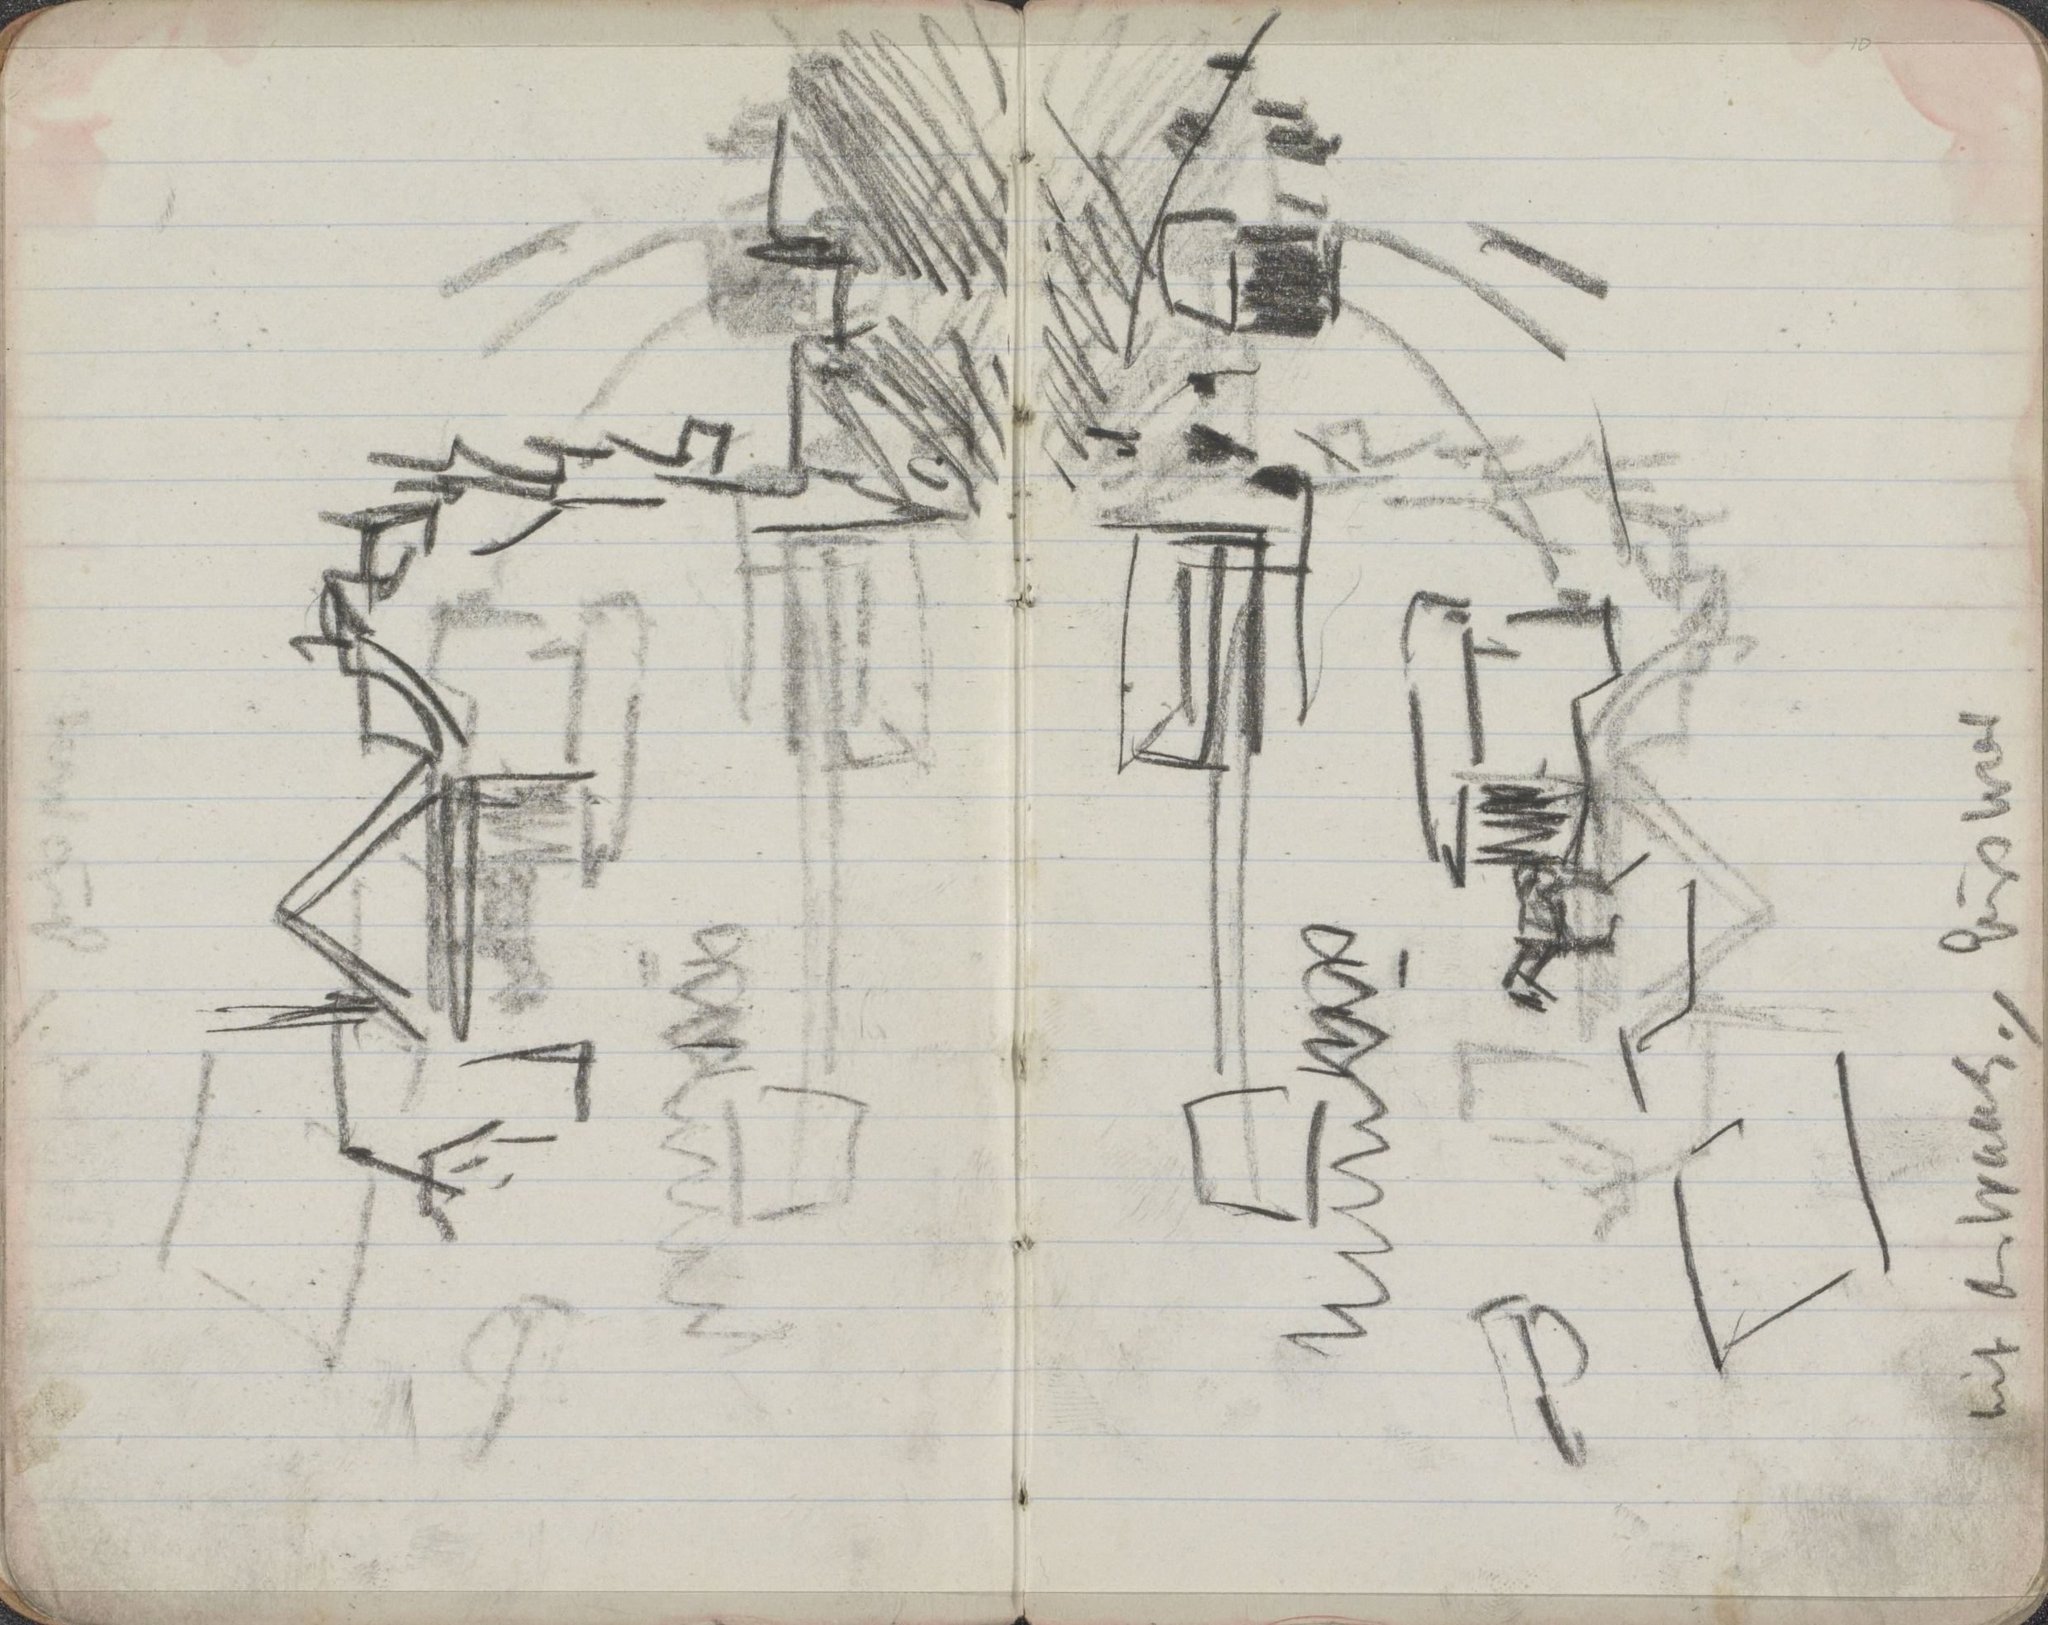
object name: sketchbook leaf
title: Paardentrams op de Nieuwmarkt te Amsterdam, gezien vanuit de Waag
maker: george hendrik breitner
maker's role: draughtsman, painter, print maker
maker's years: 1857-1923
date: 1892-1900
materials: chalk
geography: amsterdam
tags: square, place, circus, etc., diligence, omnibus, horse-tram, civic architecture; edifices; dwellings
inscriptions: annotation: ‘uit de Waag, grijs weer’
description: Pagina 9 en pagina 10 uit een schetsboek met 38 bladen.